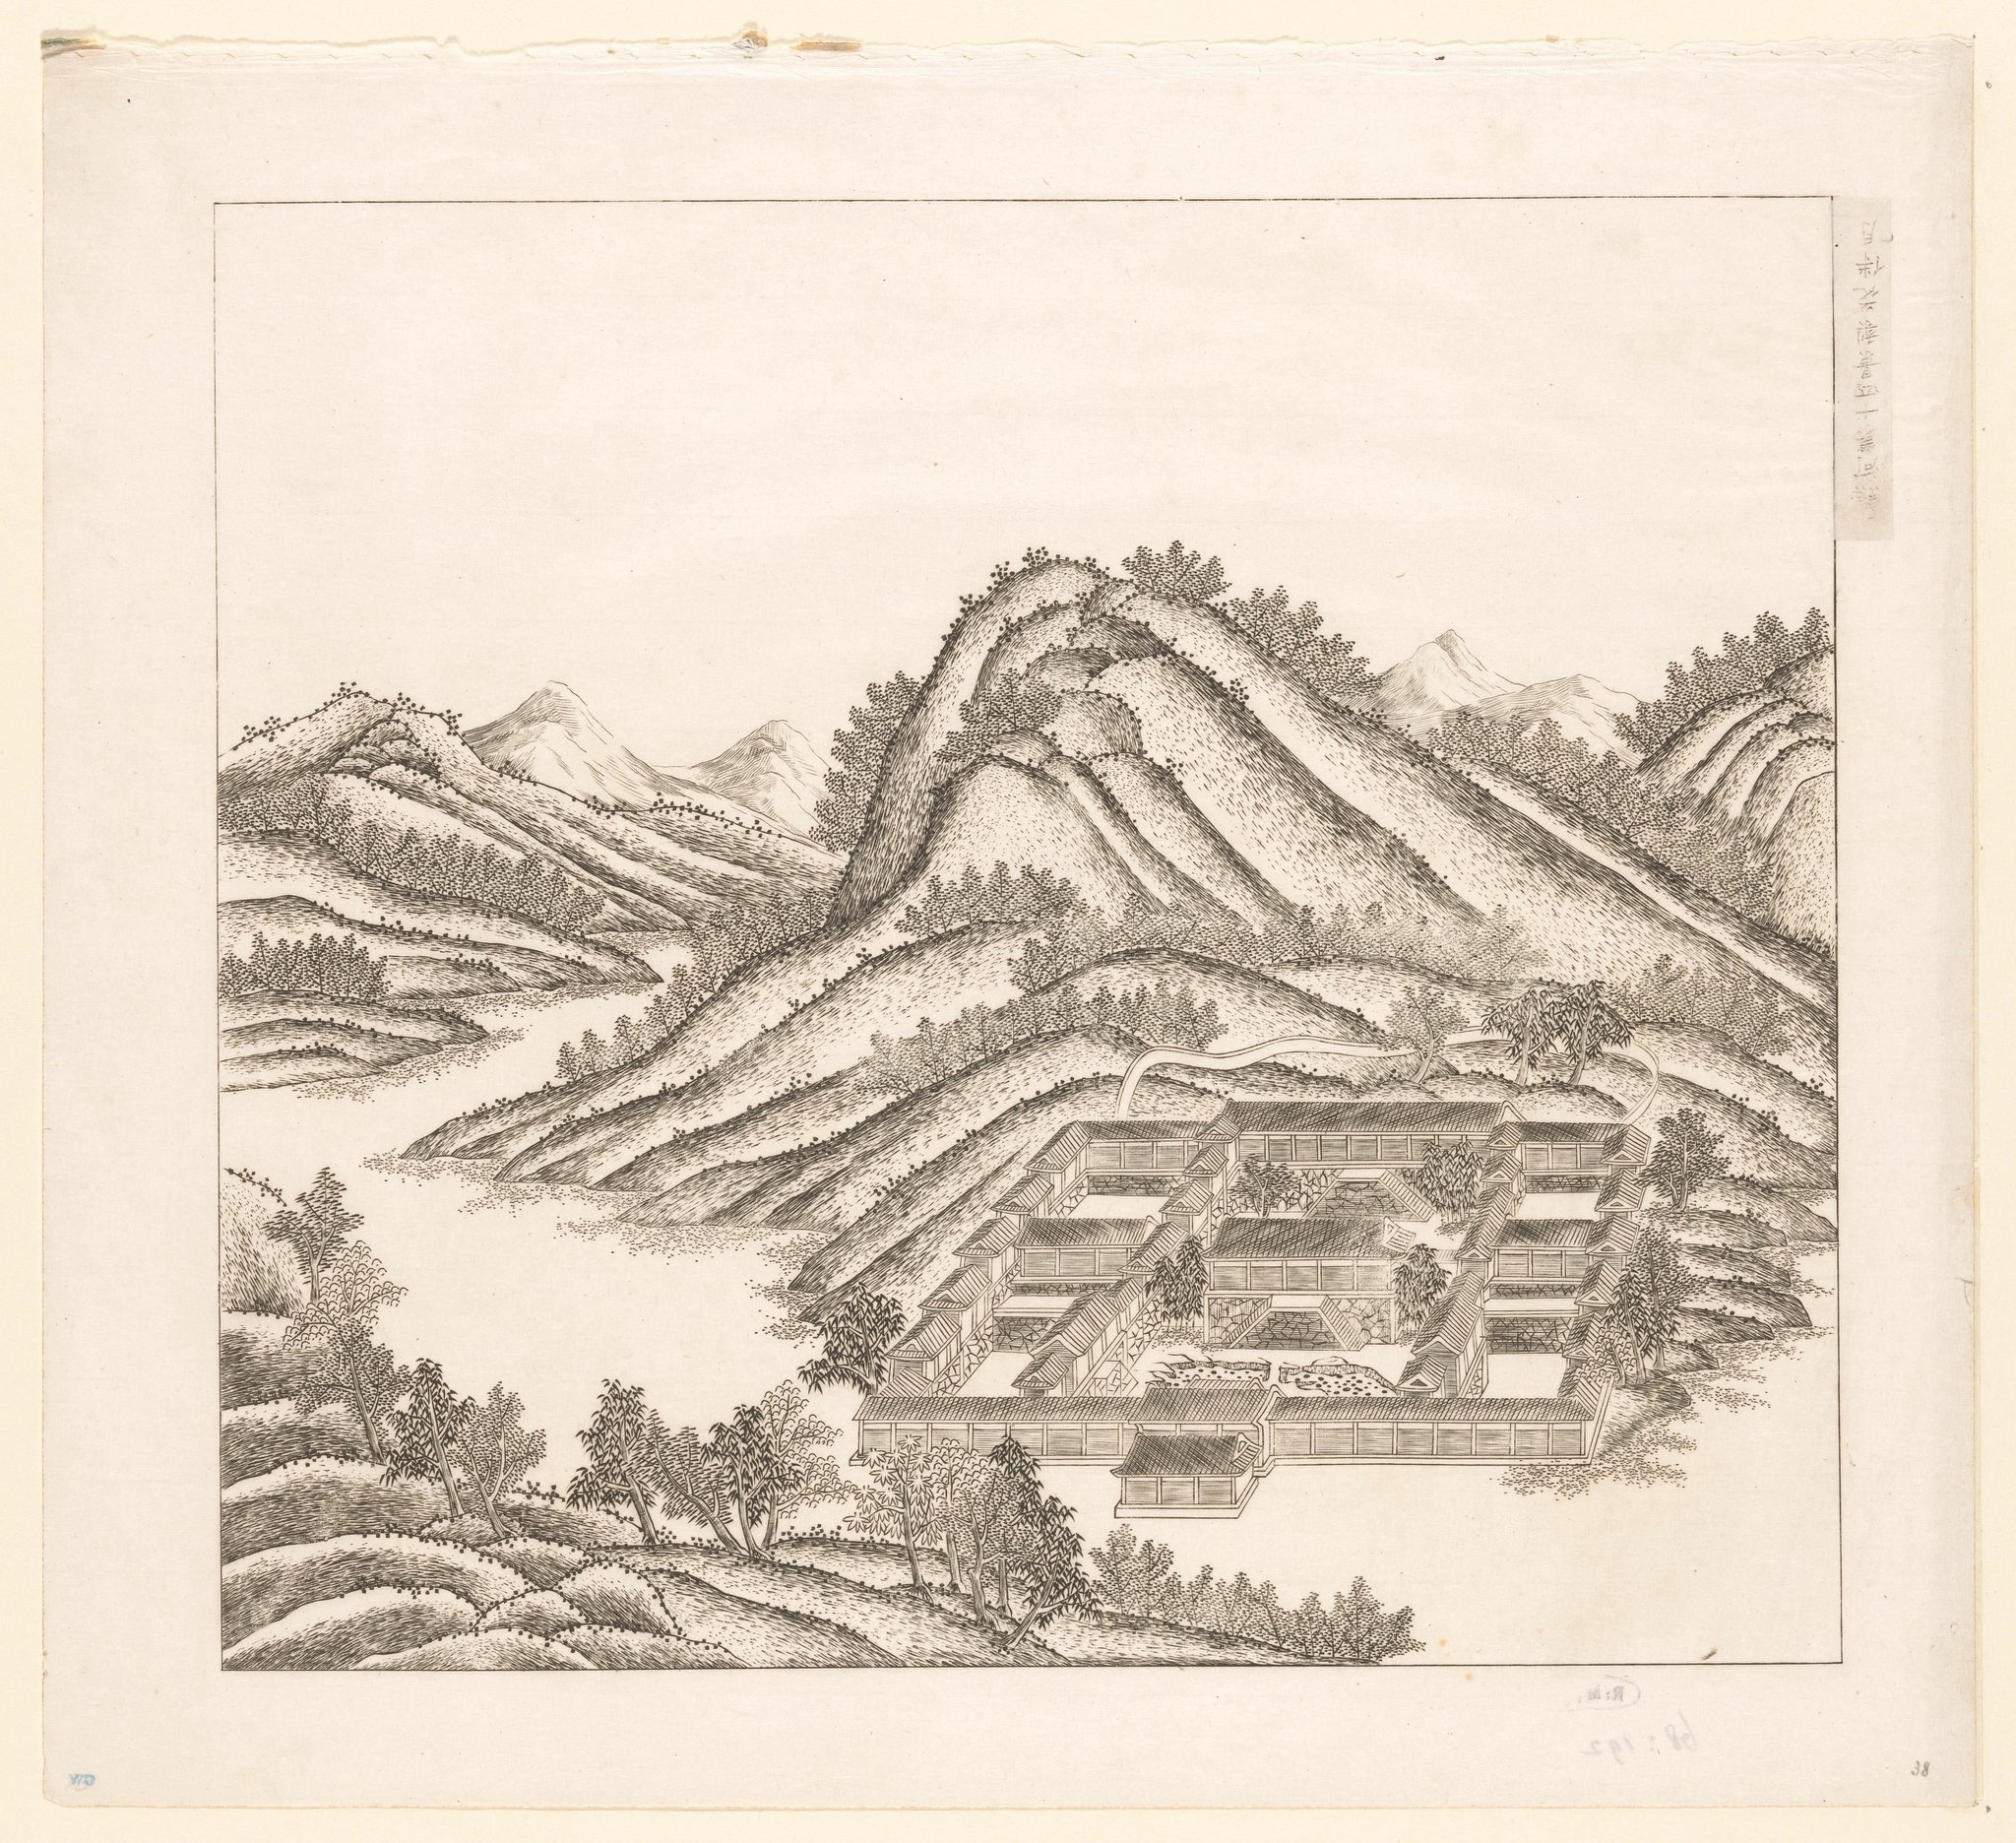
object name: print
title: Gezicht op een deel van het keizerlijk zomerpaleis in Chengde (Jehol) te China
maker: matteo ripa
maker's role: priest, print maker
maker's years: 1682-1746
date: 1712-1714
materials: paper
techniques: engraving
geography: china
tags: city-view, and landscape with man-made constructions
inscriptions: collector's mark: Lugt 2228, collector's mark: ‘GW’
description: Veertiende prent uit een serie van 36 prenten met gezichten op het keizerlijk zomerverblijf te Chengde (Jehol). De Italiaanse missionaris Matteo Ripa verbleef tussen 1711-1723 als kunstenaar aan hof van keizer Kangxi. Hij vervaardigde deze prentserie in samenwerking met enkele Chinese prentmakers. Uitgangspunt voor de ontwerpen van Shen Yu vormden de gedichten geschreven door keizer Kangxi. Het Rijksmuseum Amsterdam bezit 31 prenten van de serie. Twee andere prenten uit deze set worden bewaard in het British Museum (1968,0212,0.27 en 1968,0212,0.28).